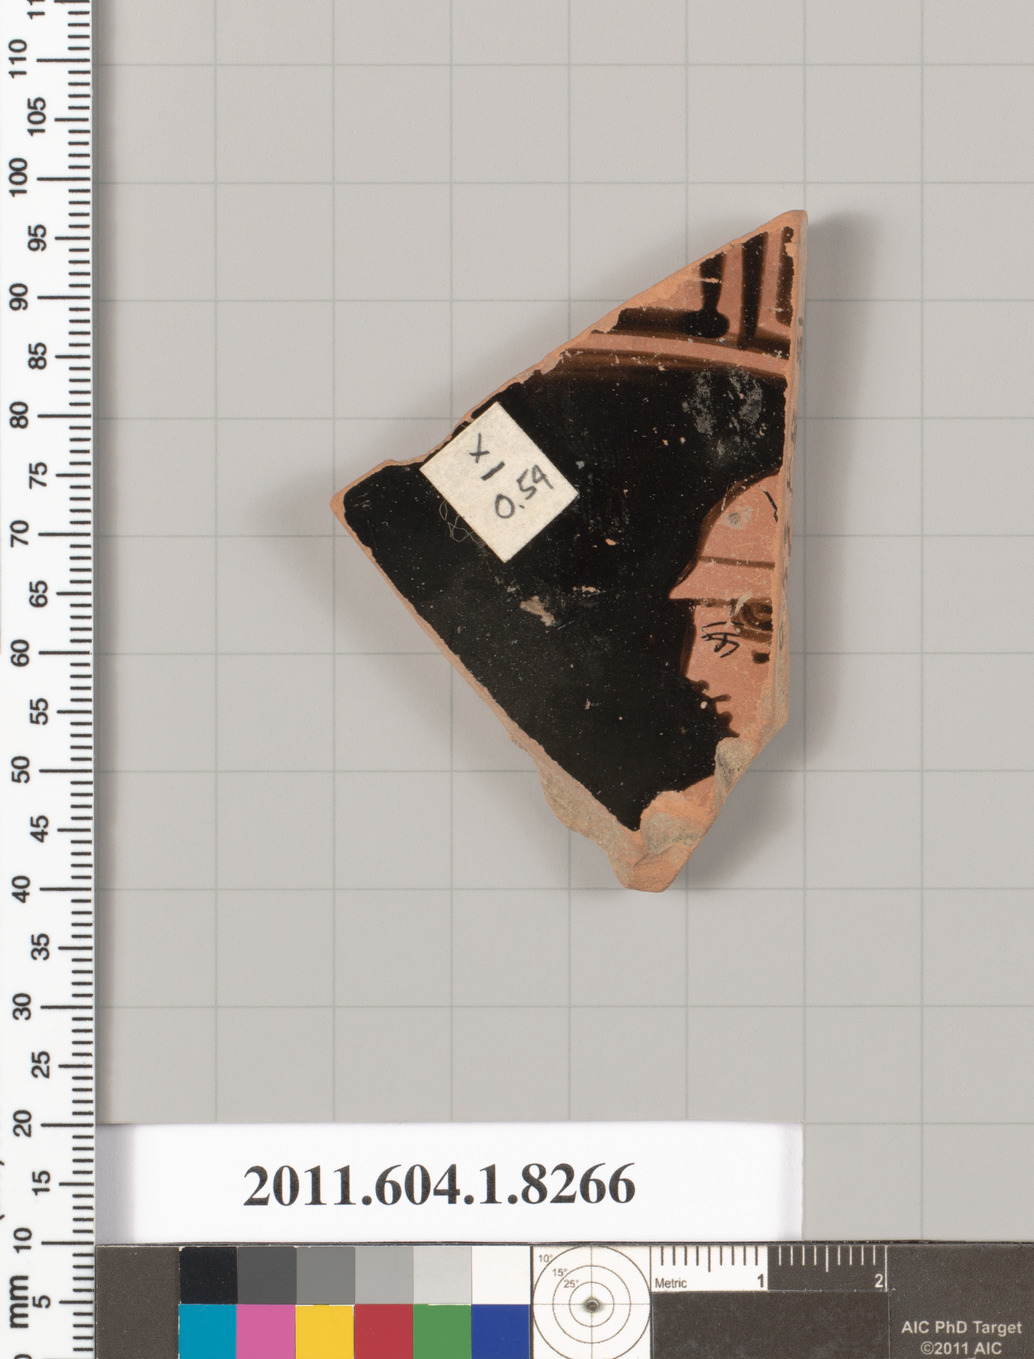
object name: kylix fragment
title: Terracotta fragment of a kylix (drinking cup)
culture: greek, attic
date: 400-376 BCE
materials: terracotta